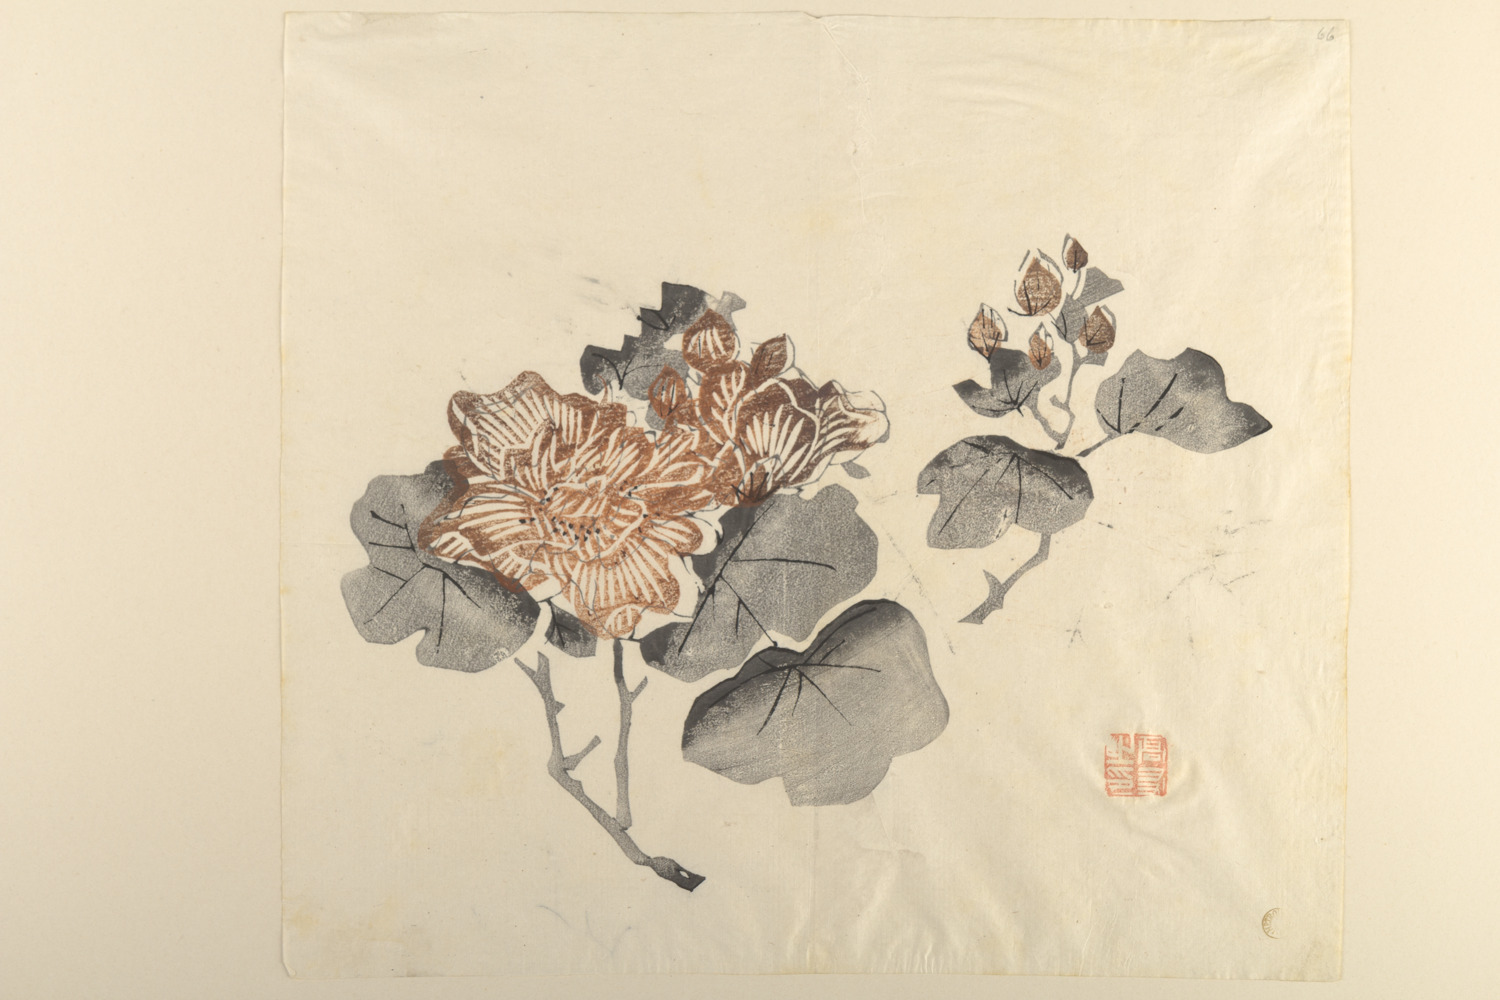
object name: print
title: Page from Shi Zhu Zhai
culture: chinese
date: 1736-1795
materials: ink, paper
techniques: polychrome, woodblock print